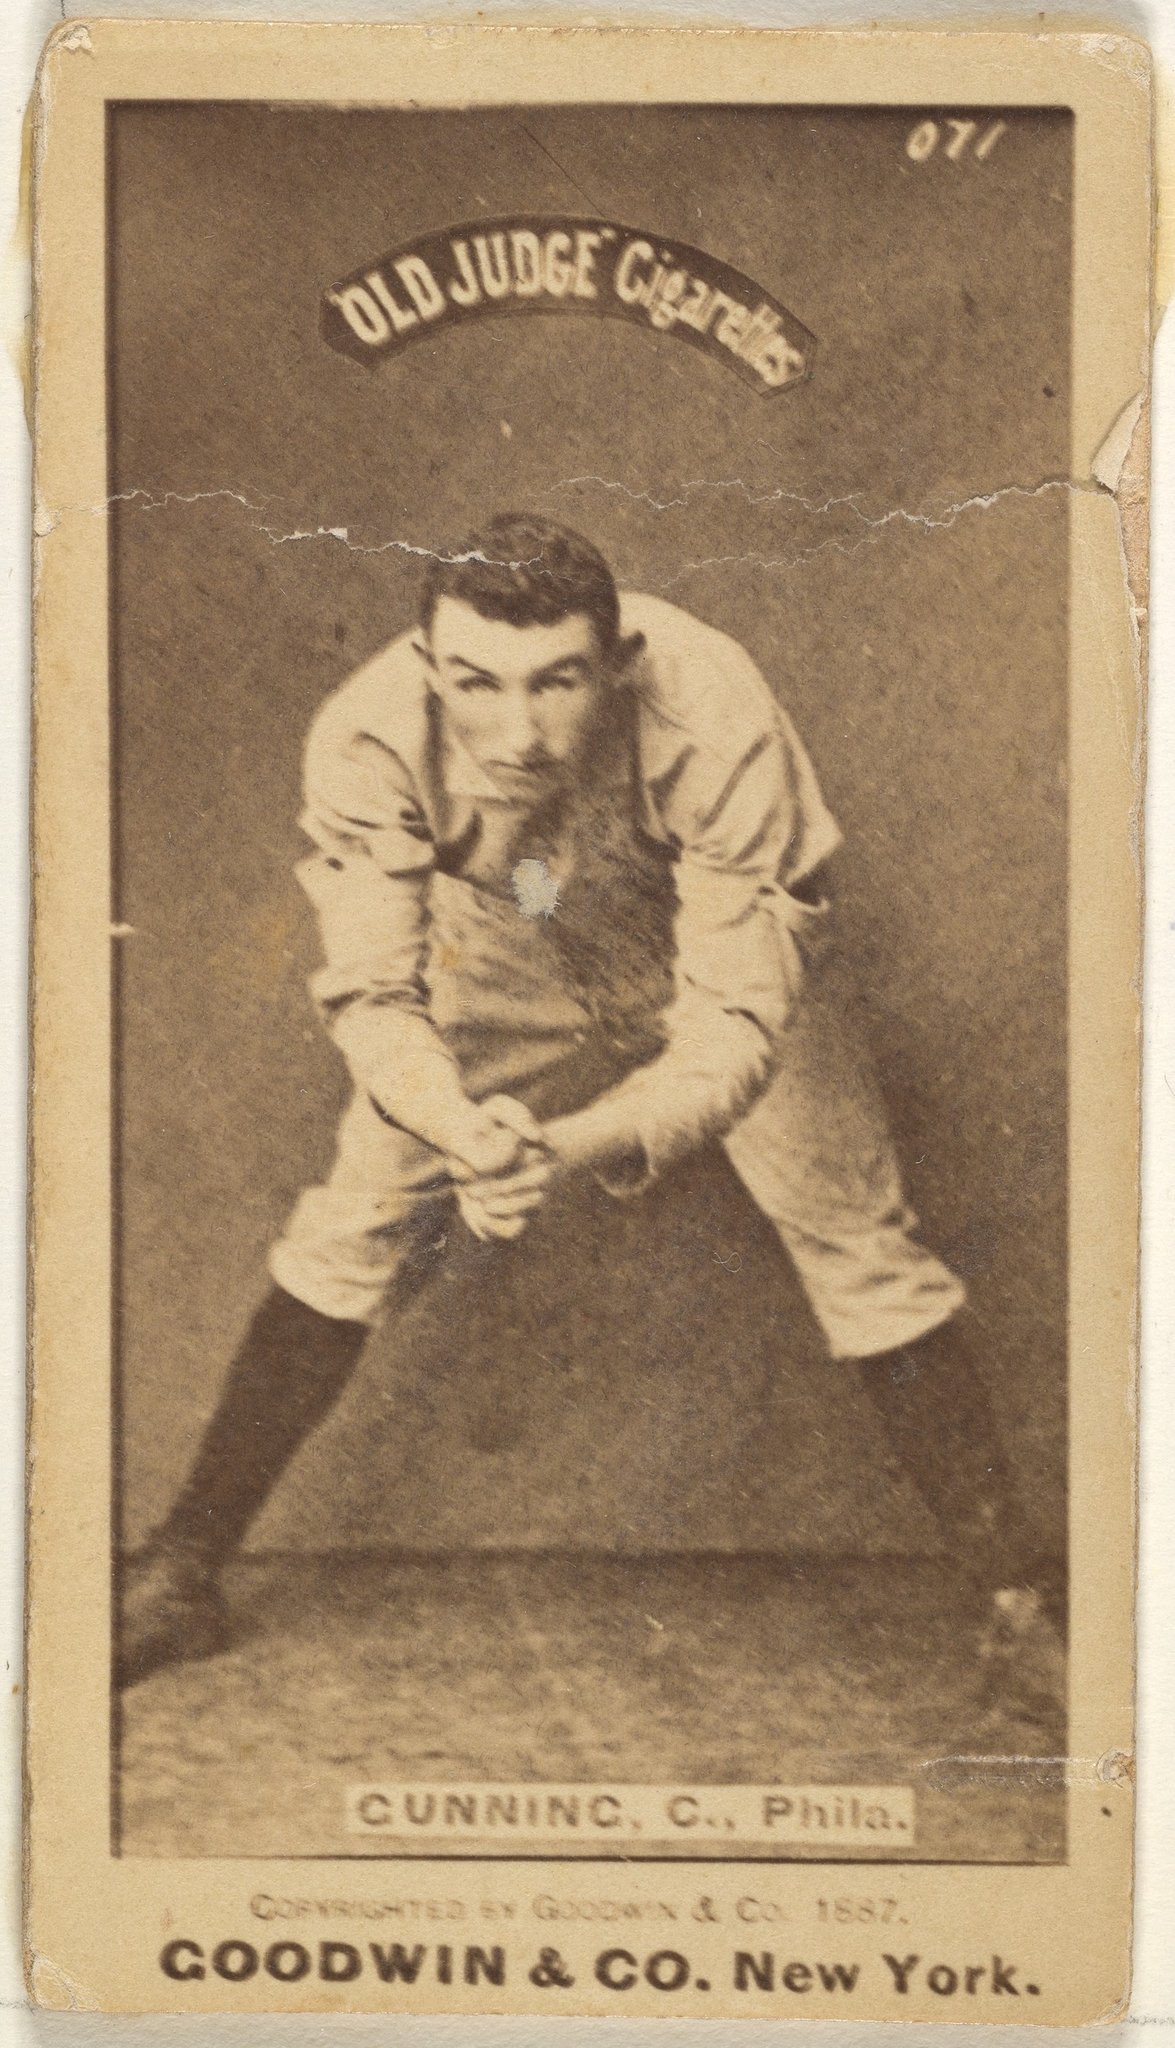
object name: baseball card, photograph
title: Thomas Francis Gunning, Catcher, Philadelphia, from the Old Judge series (N172) for Old Judge Cigarettes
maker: goodwin & company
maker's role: publisher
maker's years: 1850-1950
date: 1887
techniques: albumen silver print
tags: men,portraits,baseball,athletes